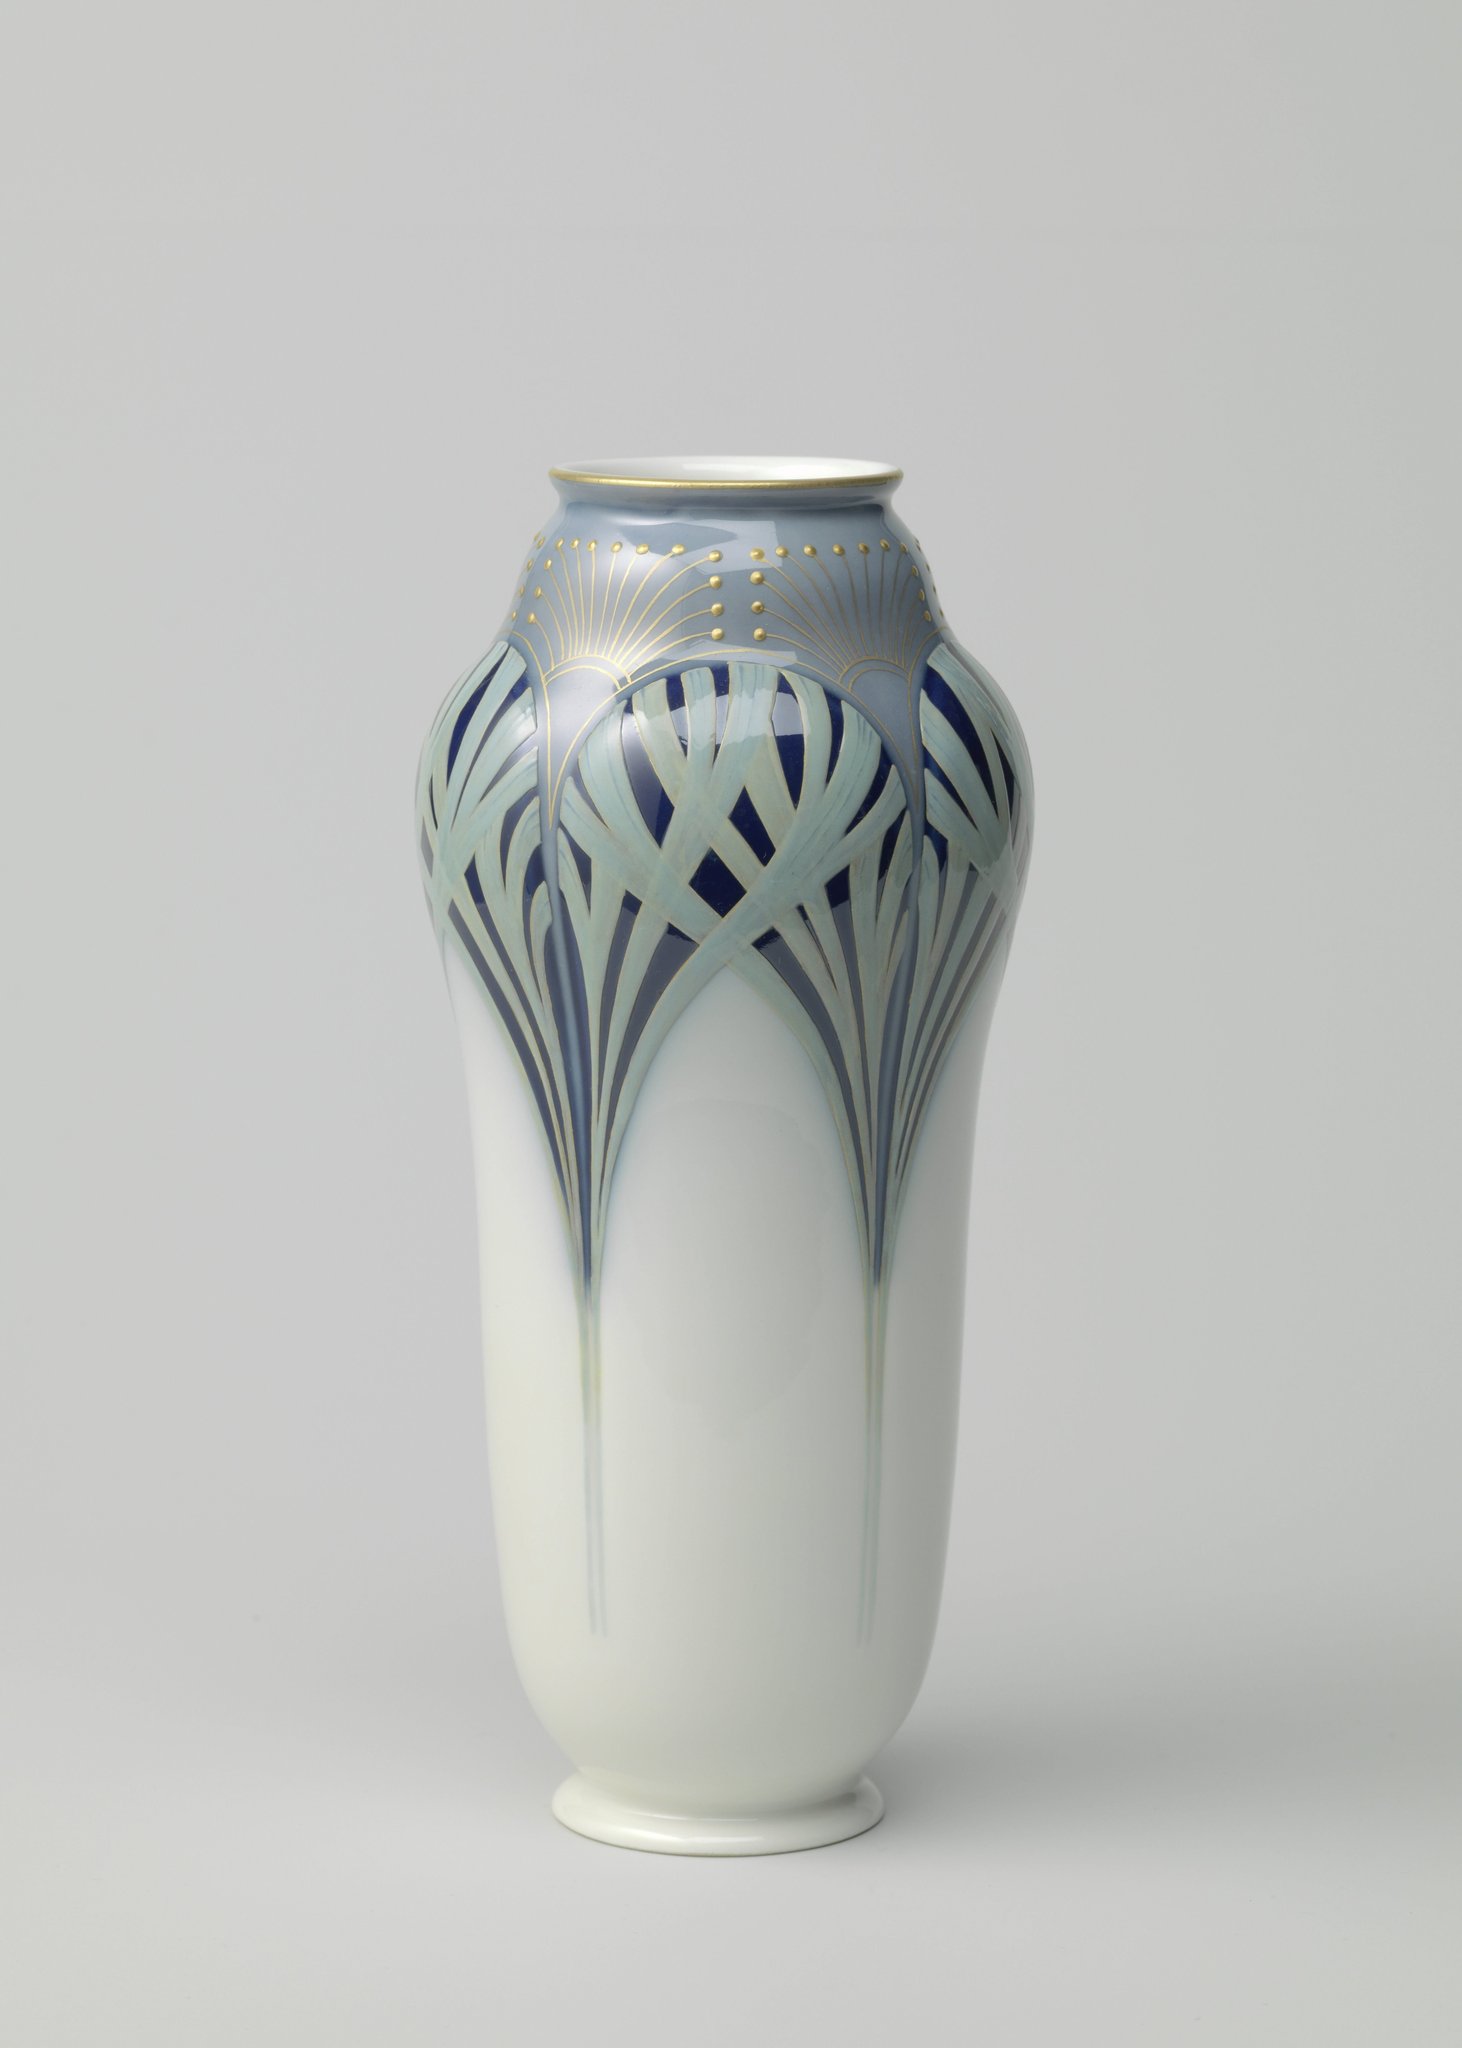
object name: vase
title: Vase with stylized leaves and an ornamental border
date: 1902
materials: cobalt, glaze, paint, porcelain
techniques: firing, forming, relief, vitrification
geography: berlin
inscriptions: mark: ‘scepter/ twee cijfers (99 of 66[?])/ 59/ rode rijksappel met 'K.P.M'/ F.B (1902)/ 672[?]1/ 9599/ diameter symbool met II.’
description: Vase. Porcelain. Berlin, Königliche Porzellan Manufaktur, 1902, possibly by Heinrich Lang.